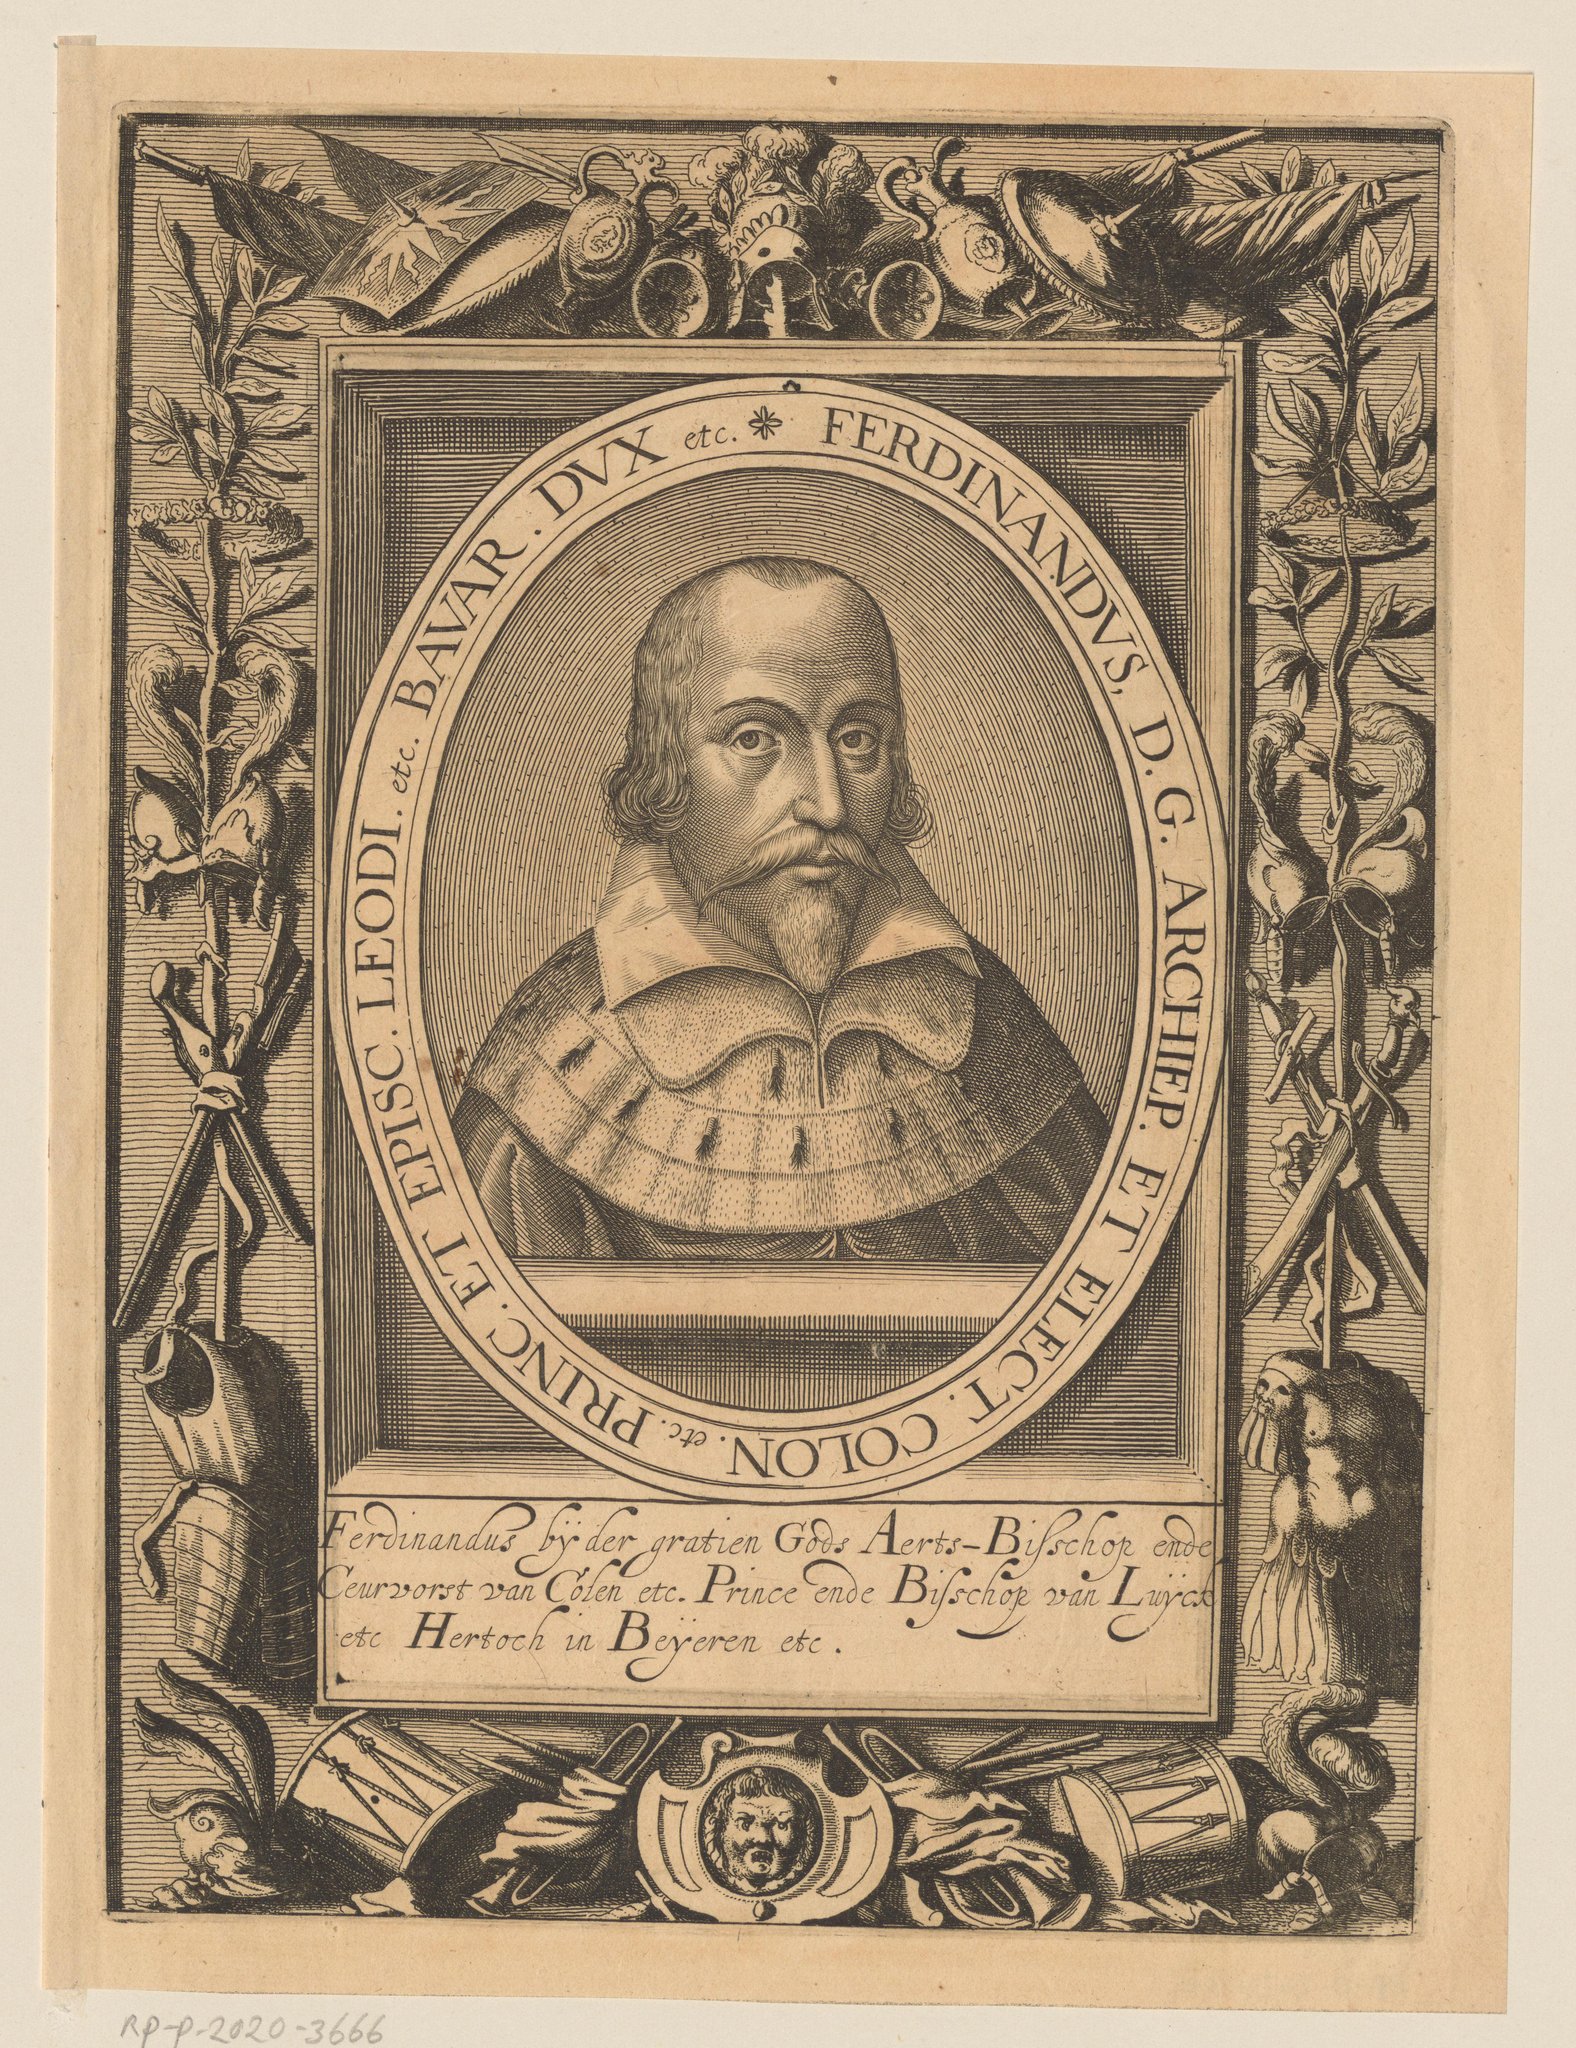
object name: print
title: Portret van Ferdinand van Beieren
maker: Anonymous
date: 1627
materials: paper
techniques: engraving, etching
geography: northern netherlands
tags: ferdinand van beieren, armour, historical persons, hacking and thrusting weapons: sword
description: Prent waarschijnlijk uit: Meteren, Emanuel van. Der Niderländischer historien Ander Thail (...). Amsterdam: Johannes Janssonius, 1627. Prent mogelijk ook gebruikt in andere edities en vertalingen van Emanuel van Meterens 'Nederlantsche Historien'.